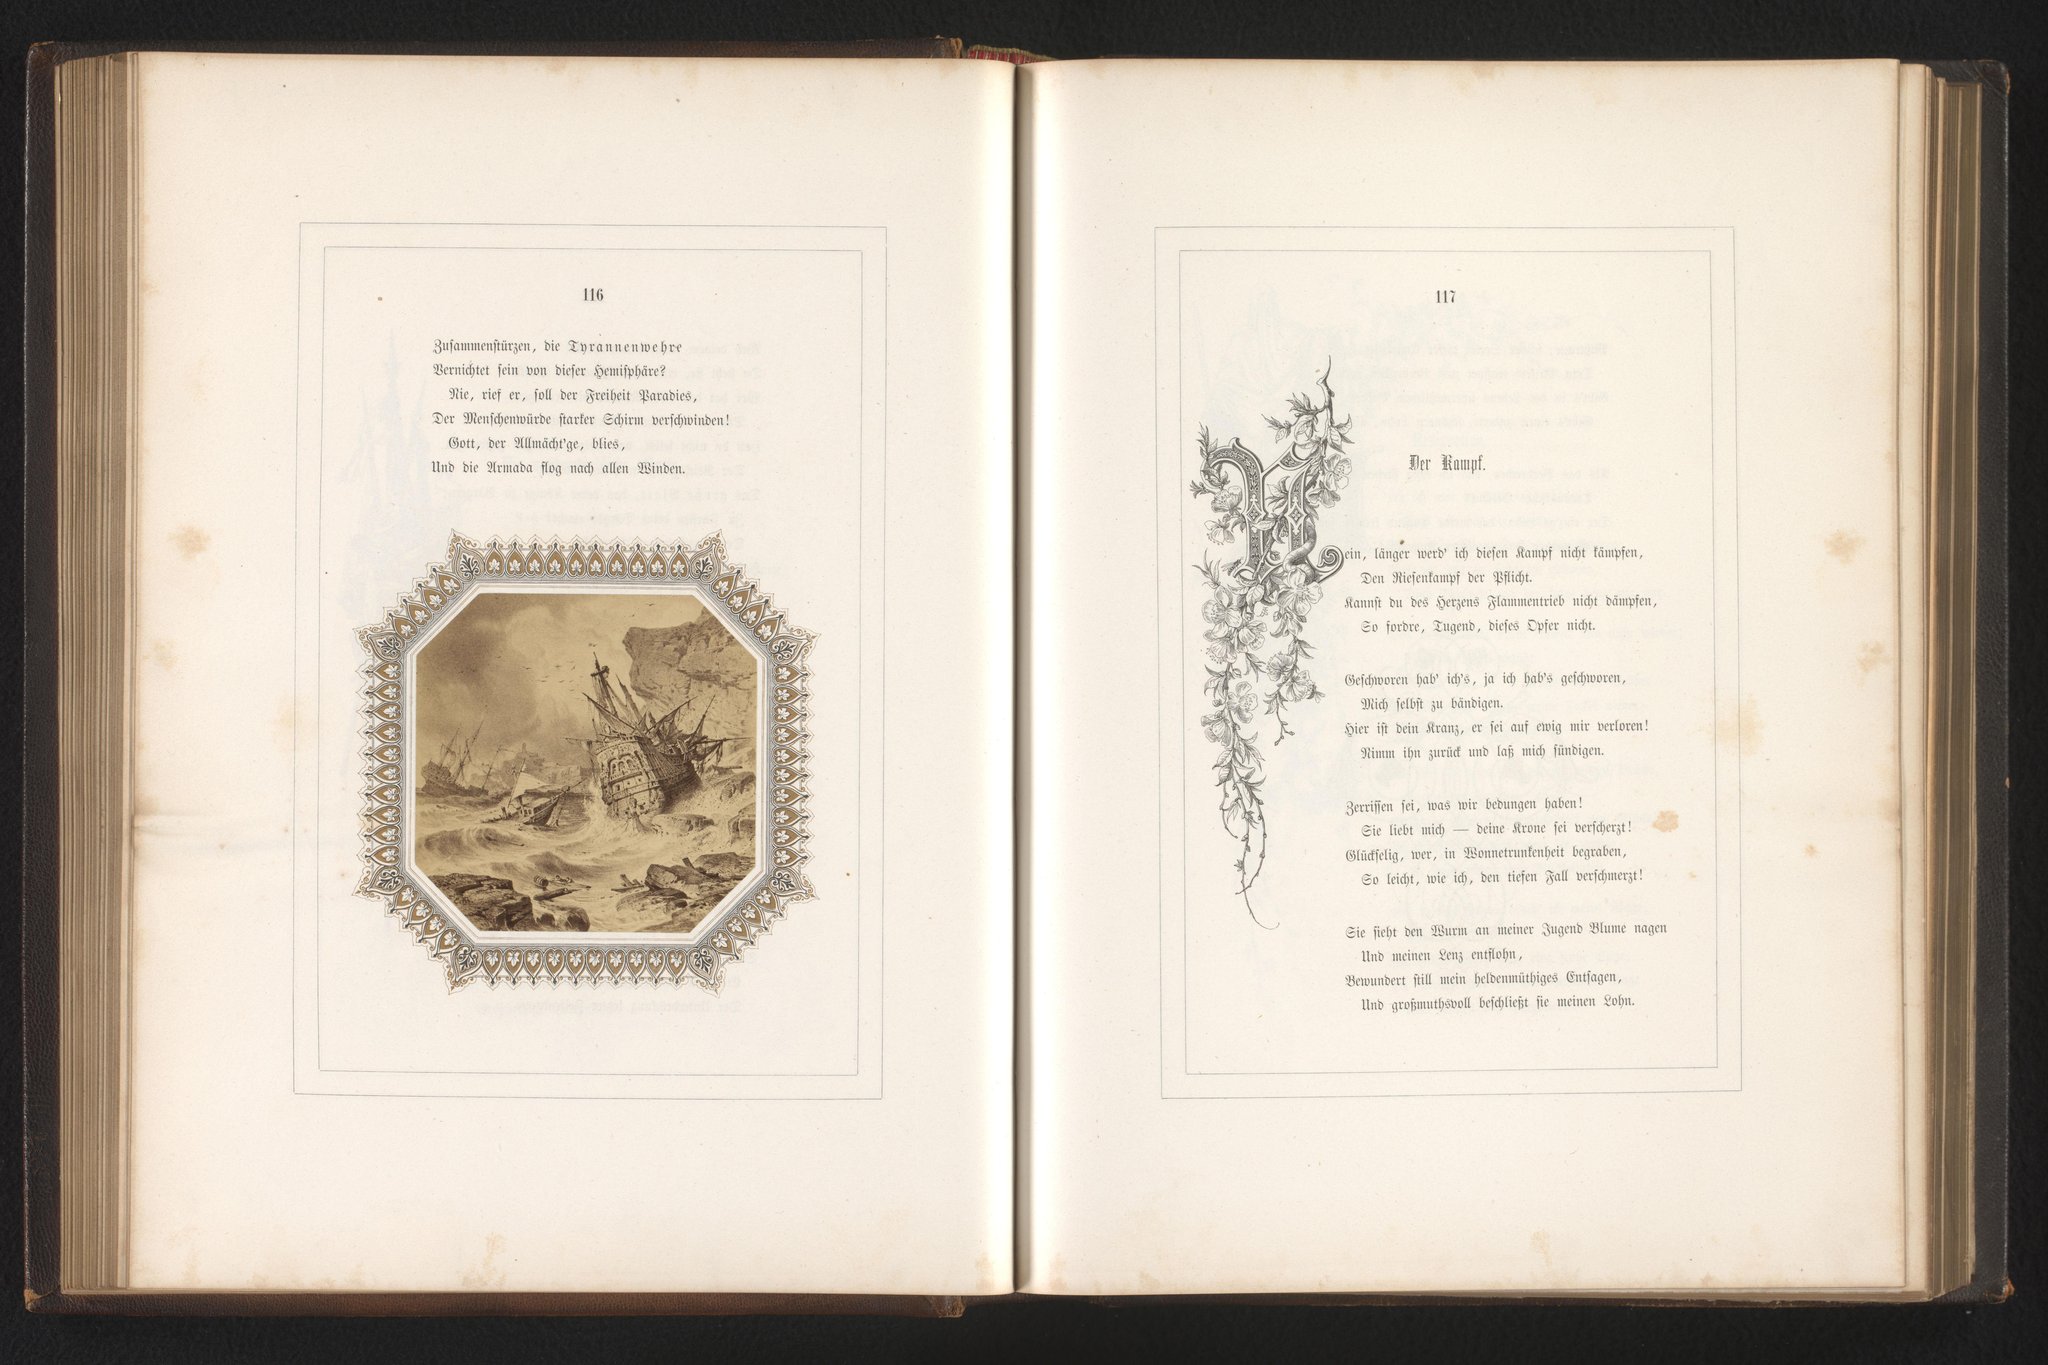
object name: page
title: Kirchner: Die unüberwindliche Flotte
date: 1855-1862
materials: paper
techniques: albumen print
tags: shipwreck, ships (in general) - cc - more than one ship